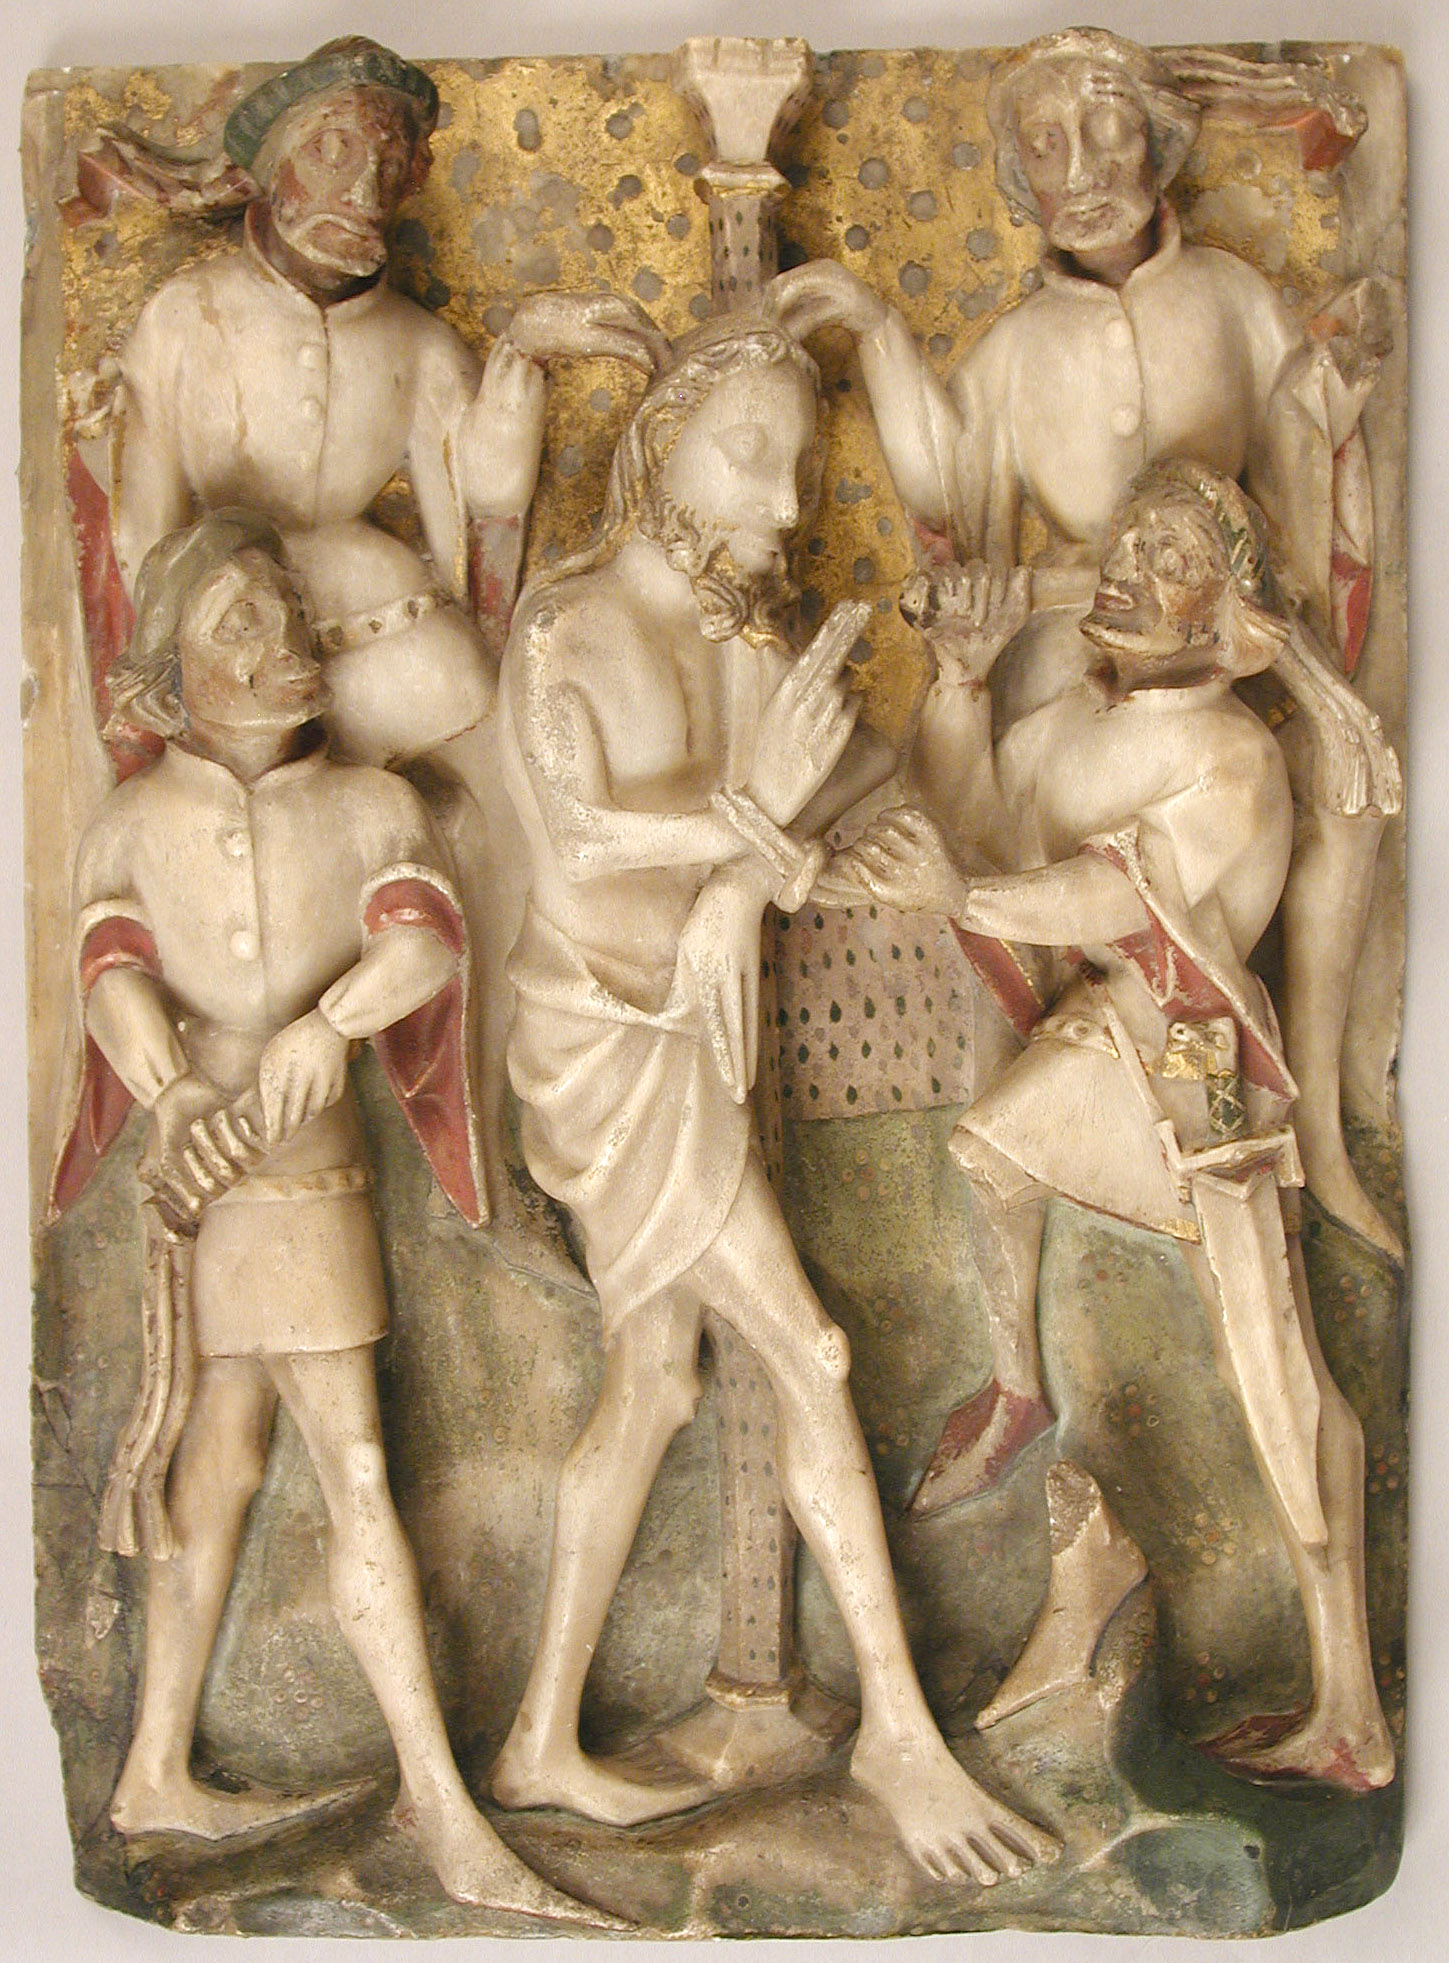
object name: plaque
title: Taking of Christ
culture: british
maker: school of nottingham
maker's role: artist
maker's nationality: british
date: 1440-1450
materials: alabaster, paint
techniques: gilding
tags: men